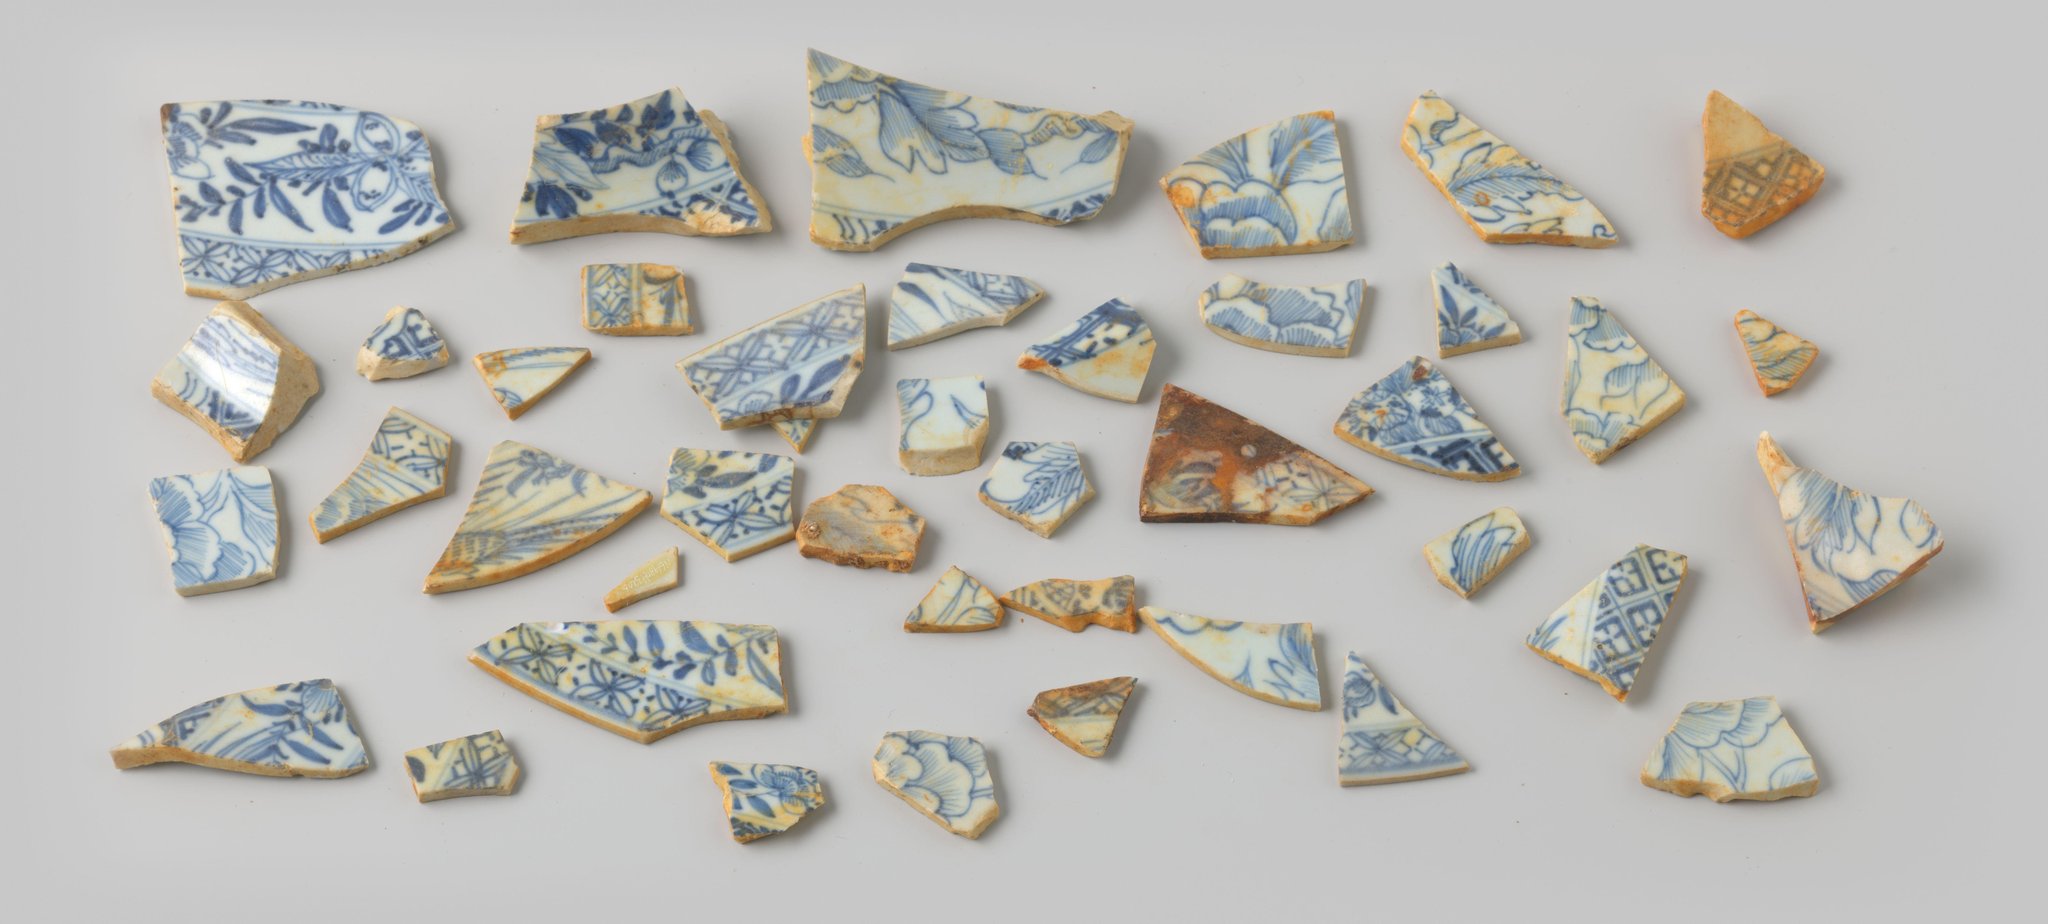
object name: sherd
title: Scherven van een bord uit het wrak van de Oost-Indiëvaarder Hollandia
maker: Anonymous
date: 1700-1743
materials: porcelain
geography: netherlands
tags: verenigde oostindische compagnie, hollandia (schip), annet